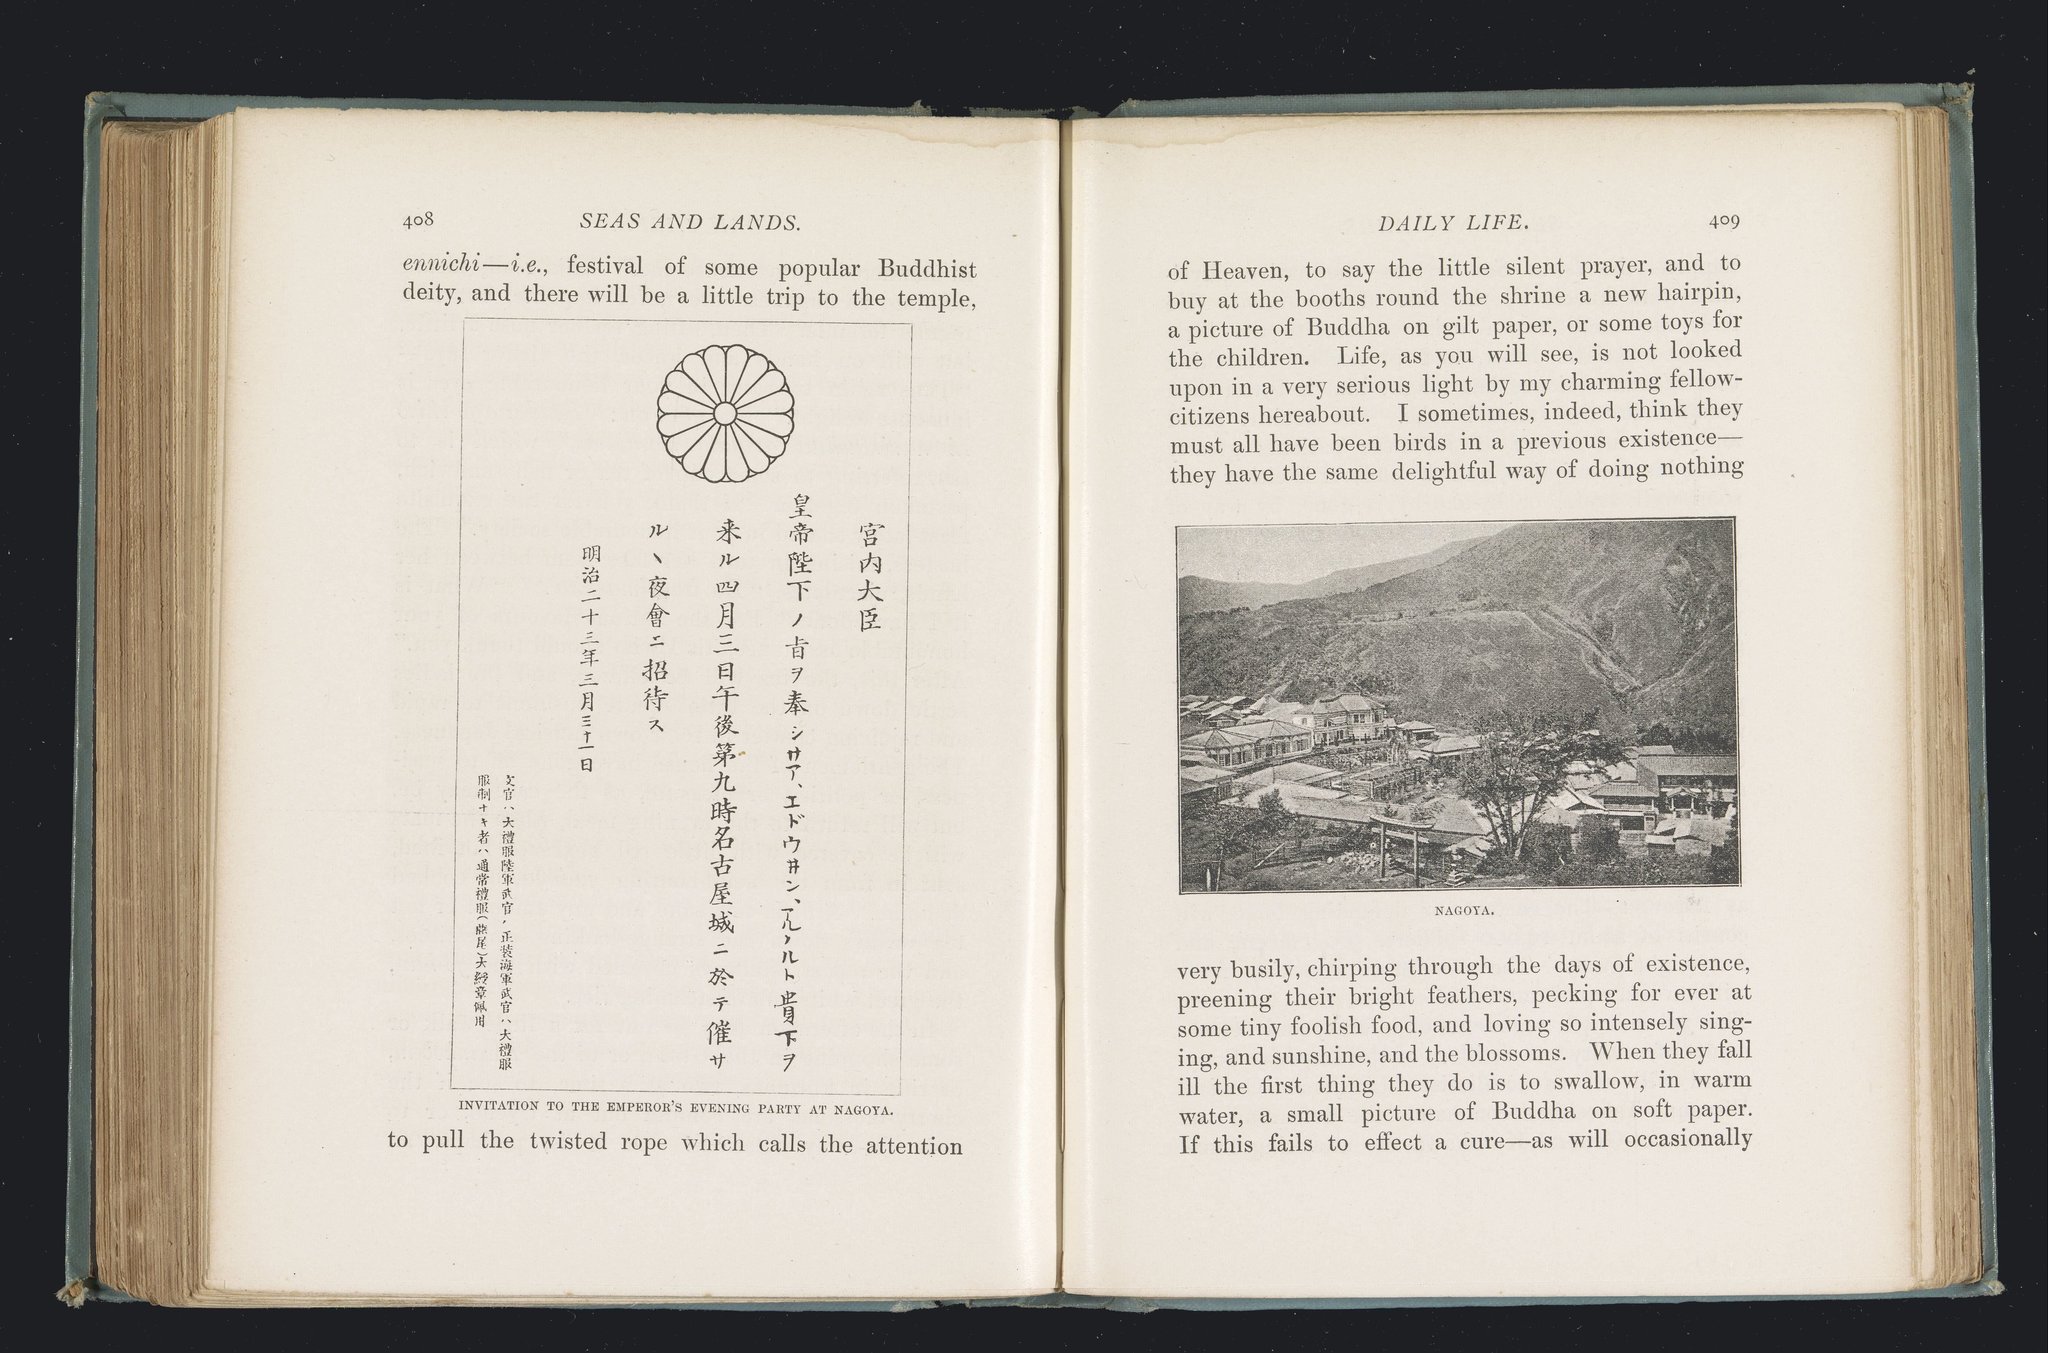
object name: page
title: Nagoya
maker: Anonymous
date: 1882-1892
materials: paper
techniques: autotype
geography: japan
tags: city-view, and landscape with man-made constructions